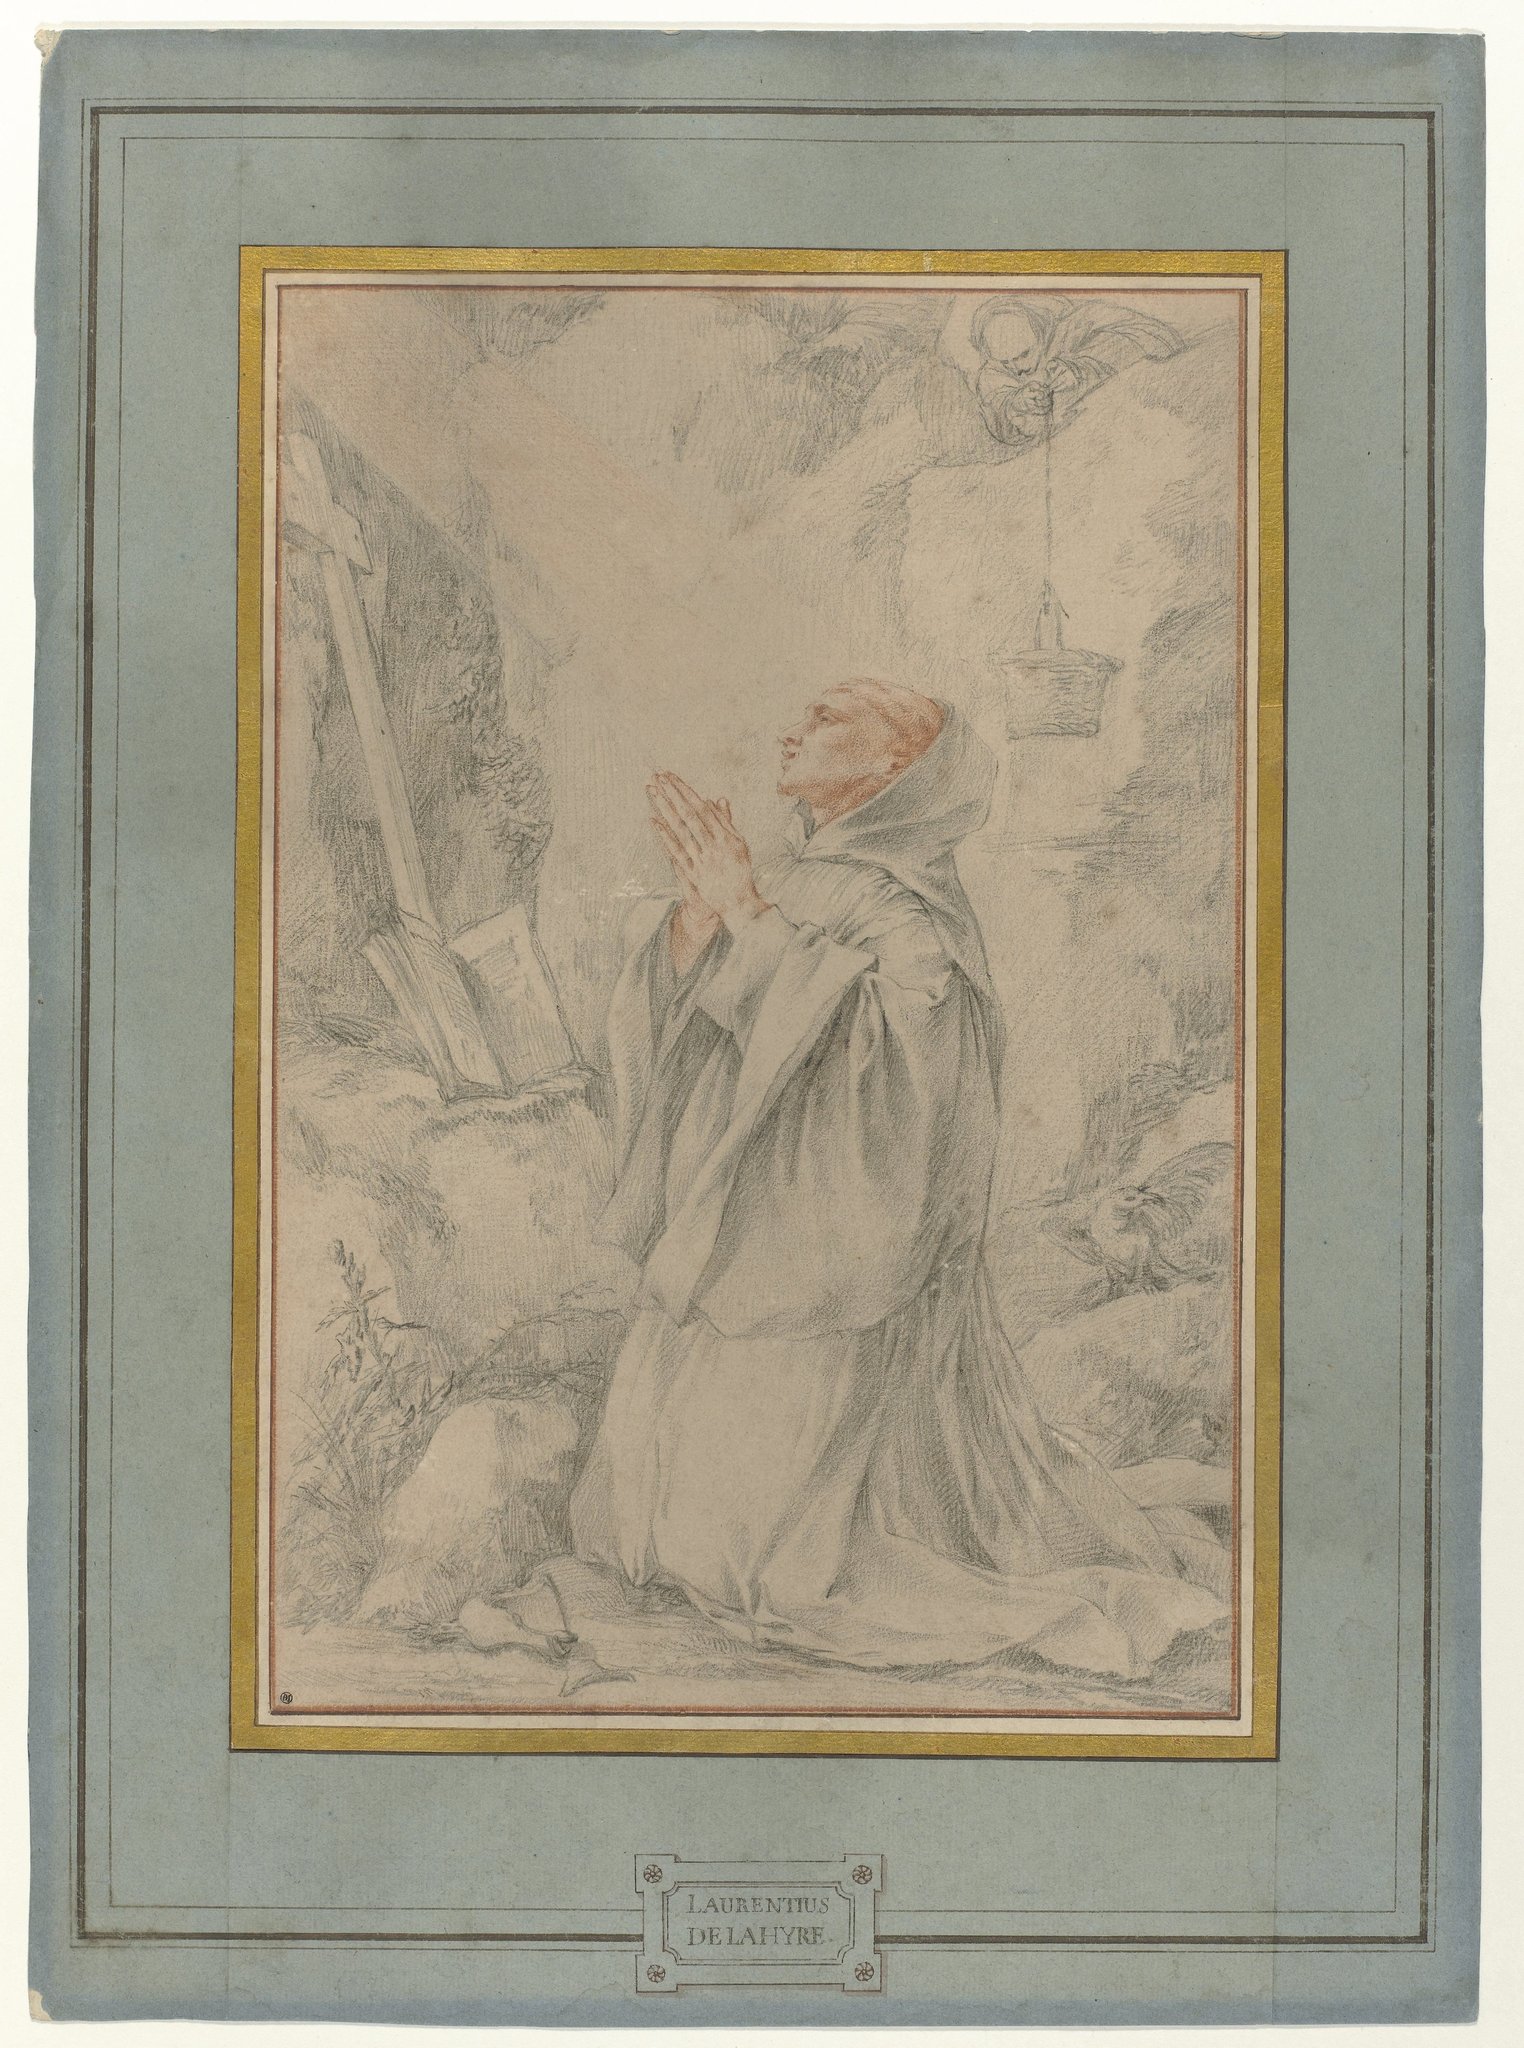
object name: drawing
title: H. Benedictus biddend in een grot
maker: laurent de la hire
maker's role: draughtsman, painter, print maker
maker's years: 1606-1656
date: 1616-1656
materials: chalk, paper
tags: benedict of nurcia, abbot of monte cassino and founder of the benedictine order; possible attributes: aspergillum, book, cup (sometimes broken), raven with loaf, sieve (or tray)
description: H. Benedictus, geknield en biddend voor een kruis in een grot. Ontwerp voor een prent.